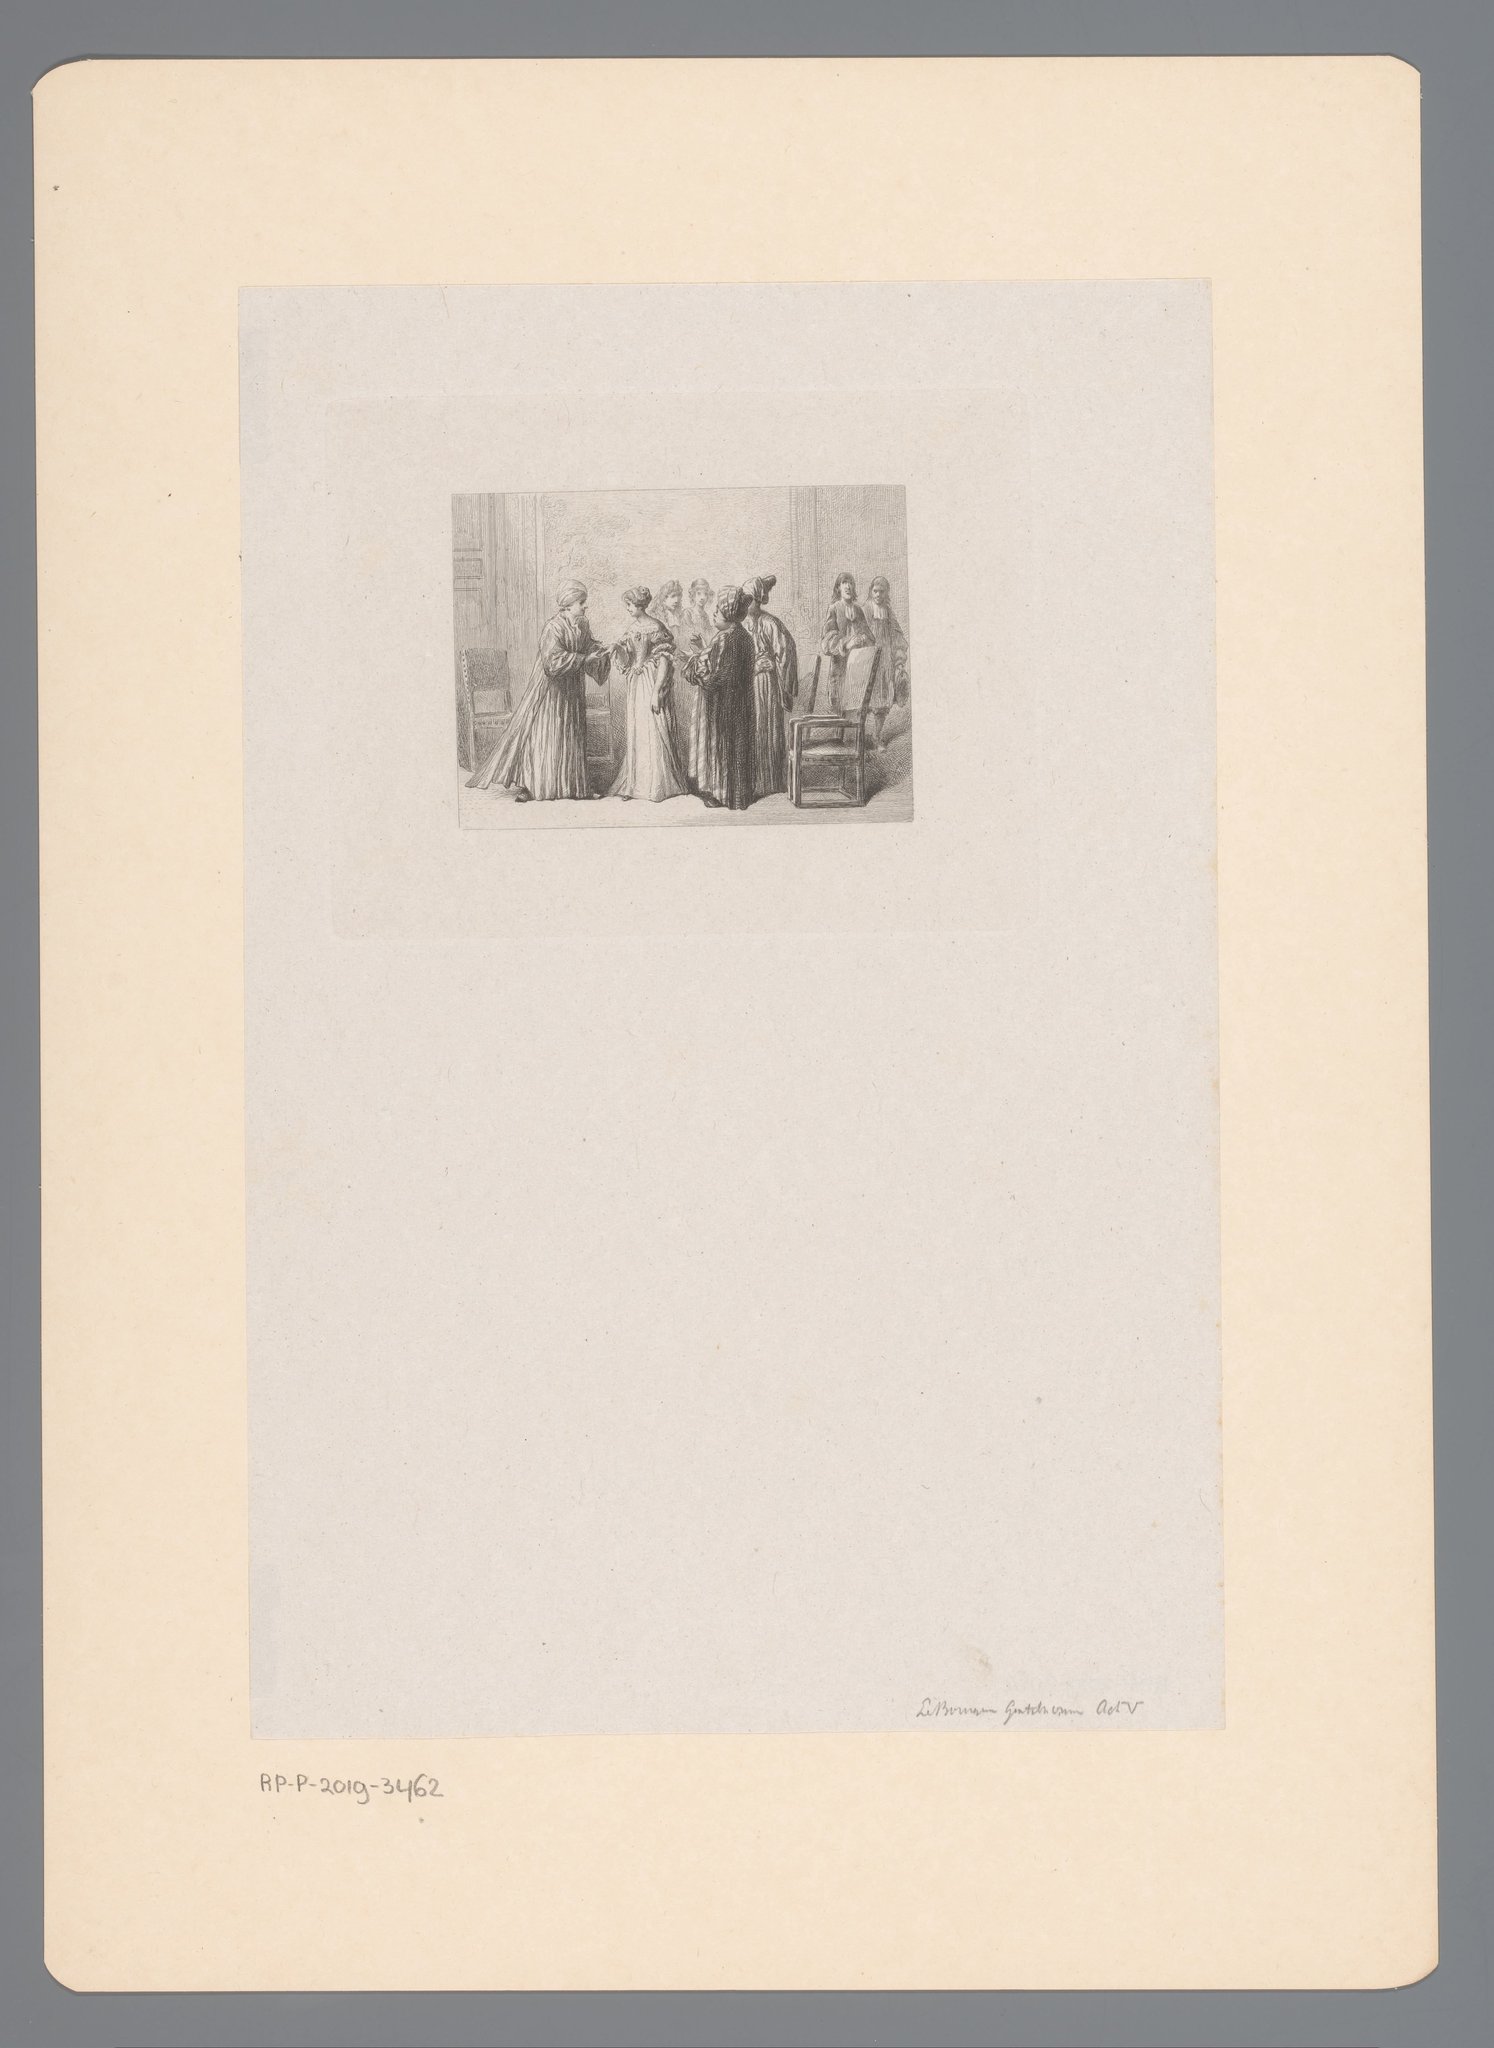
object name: print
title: Molière Théatre Choisi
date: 1878-1879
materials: paper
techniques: drypoint, etching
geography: tours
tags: lackey and other lower personnel at court, asiatic races and peoples: turks, theatre, theatrical performance, head-gear: turban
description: Akte V, scène IV of V uit "Le Bourgeois Gentilhomme" van Molière. Turkse gasten op een feest van monsieur Jourdain.